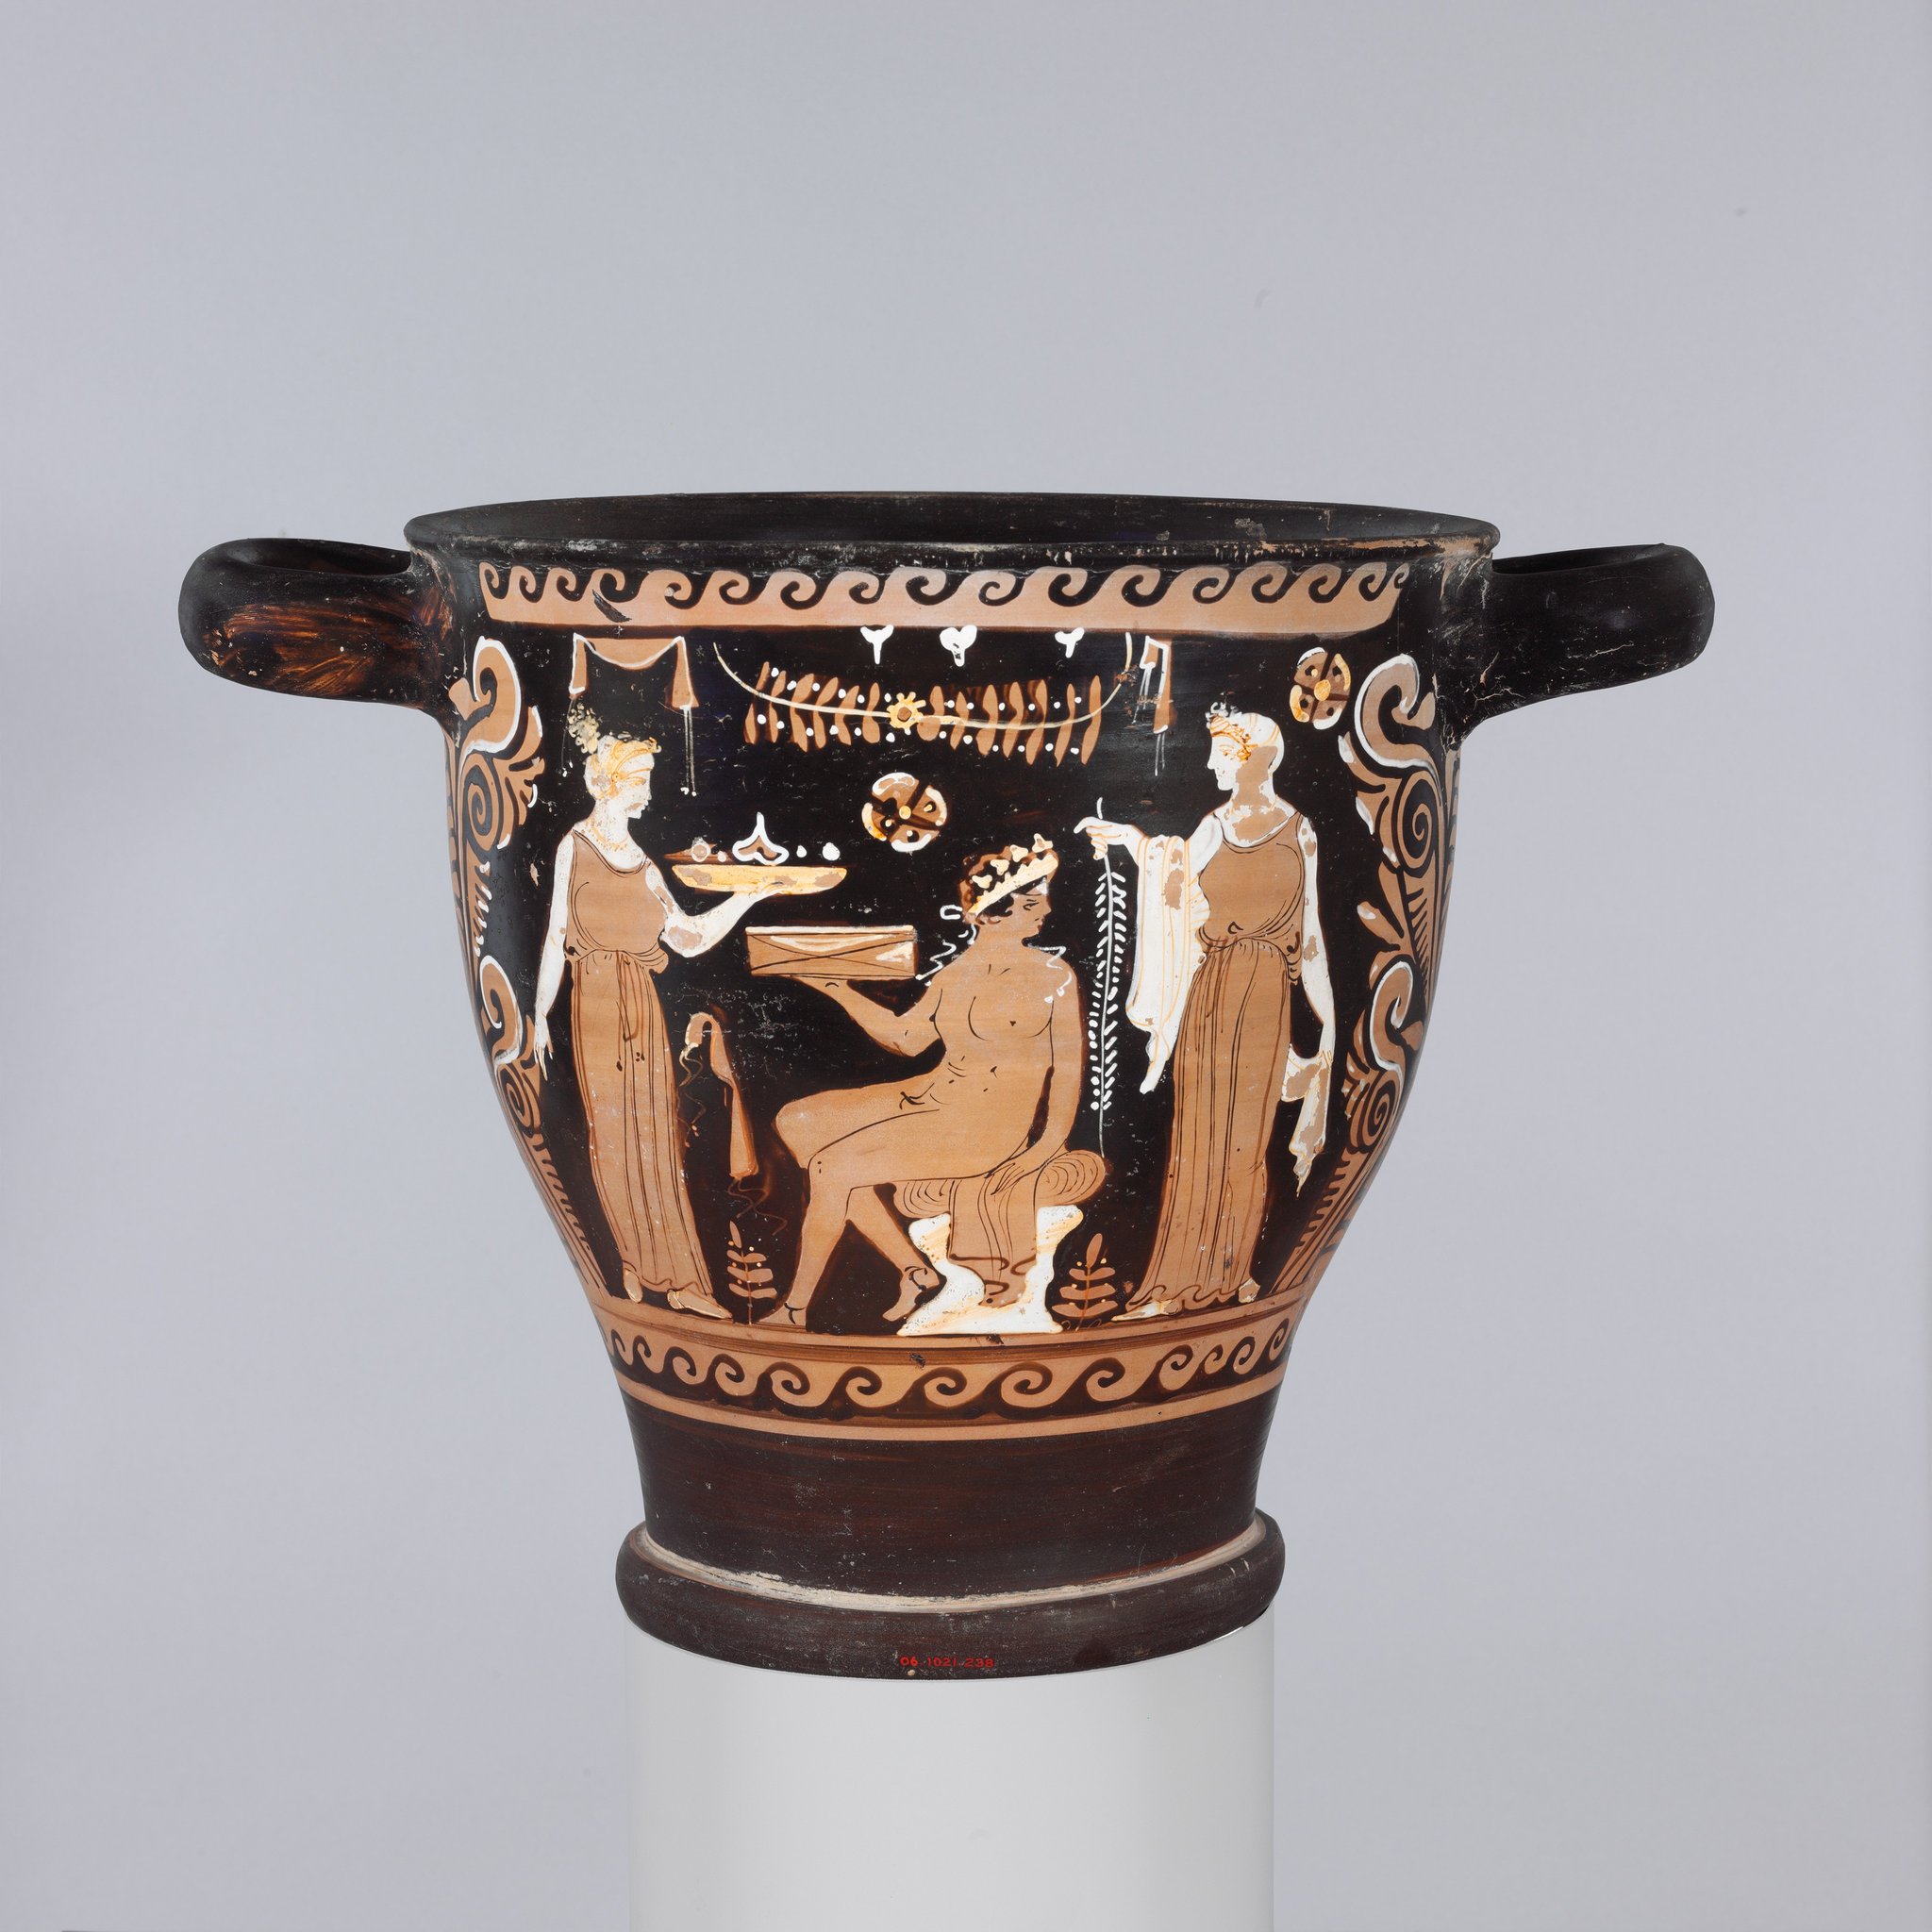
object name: skyphos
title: Terracotta skyphos (deep drinking cup)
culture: greek or south italian or campanian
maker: apz painter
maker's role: artist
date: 330-300 BCE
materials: terracotta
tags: male nudes,women